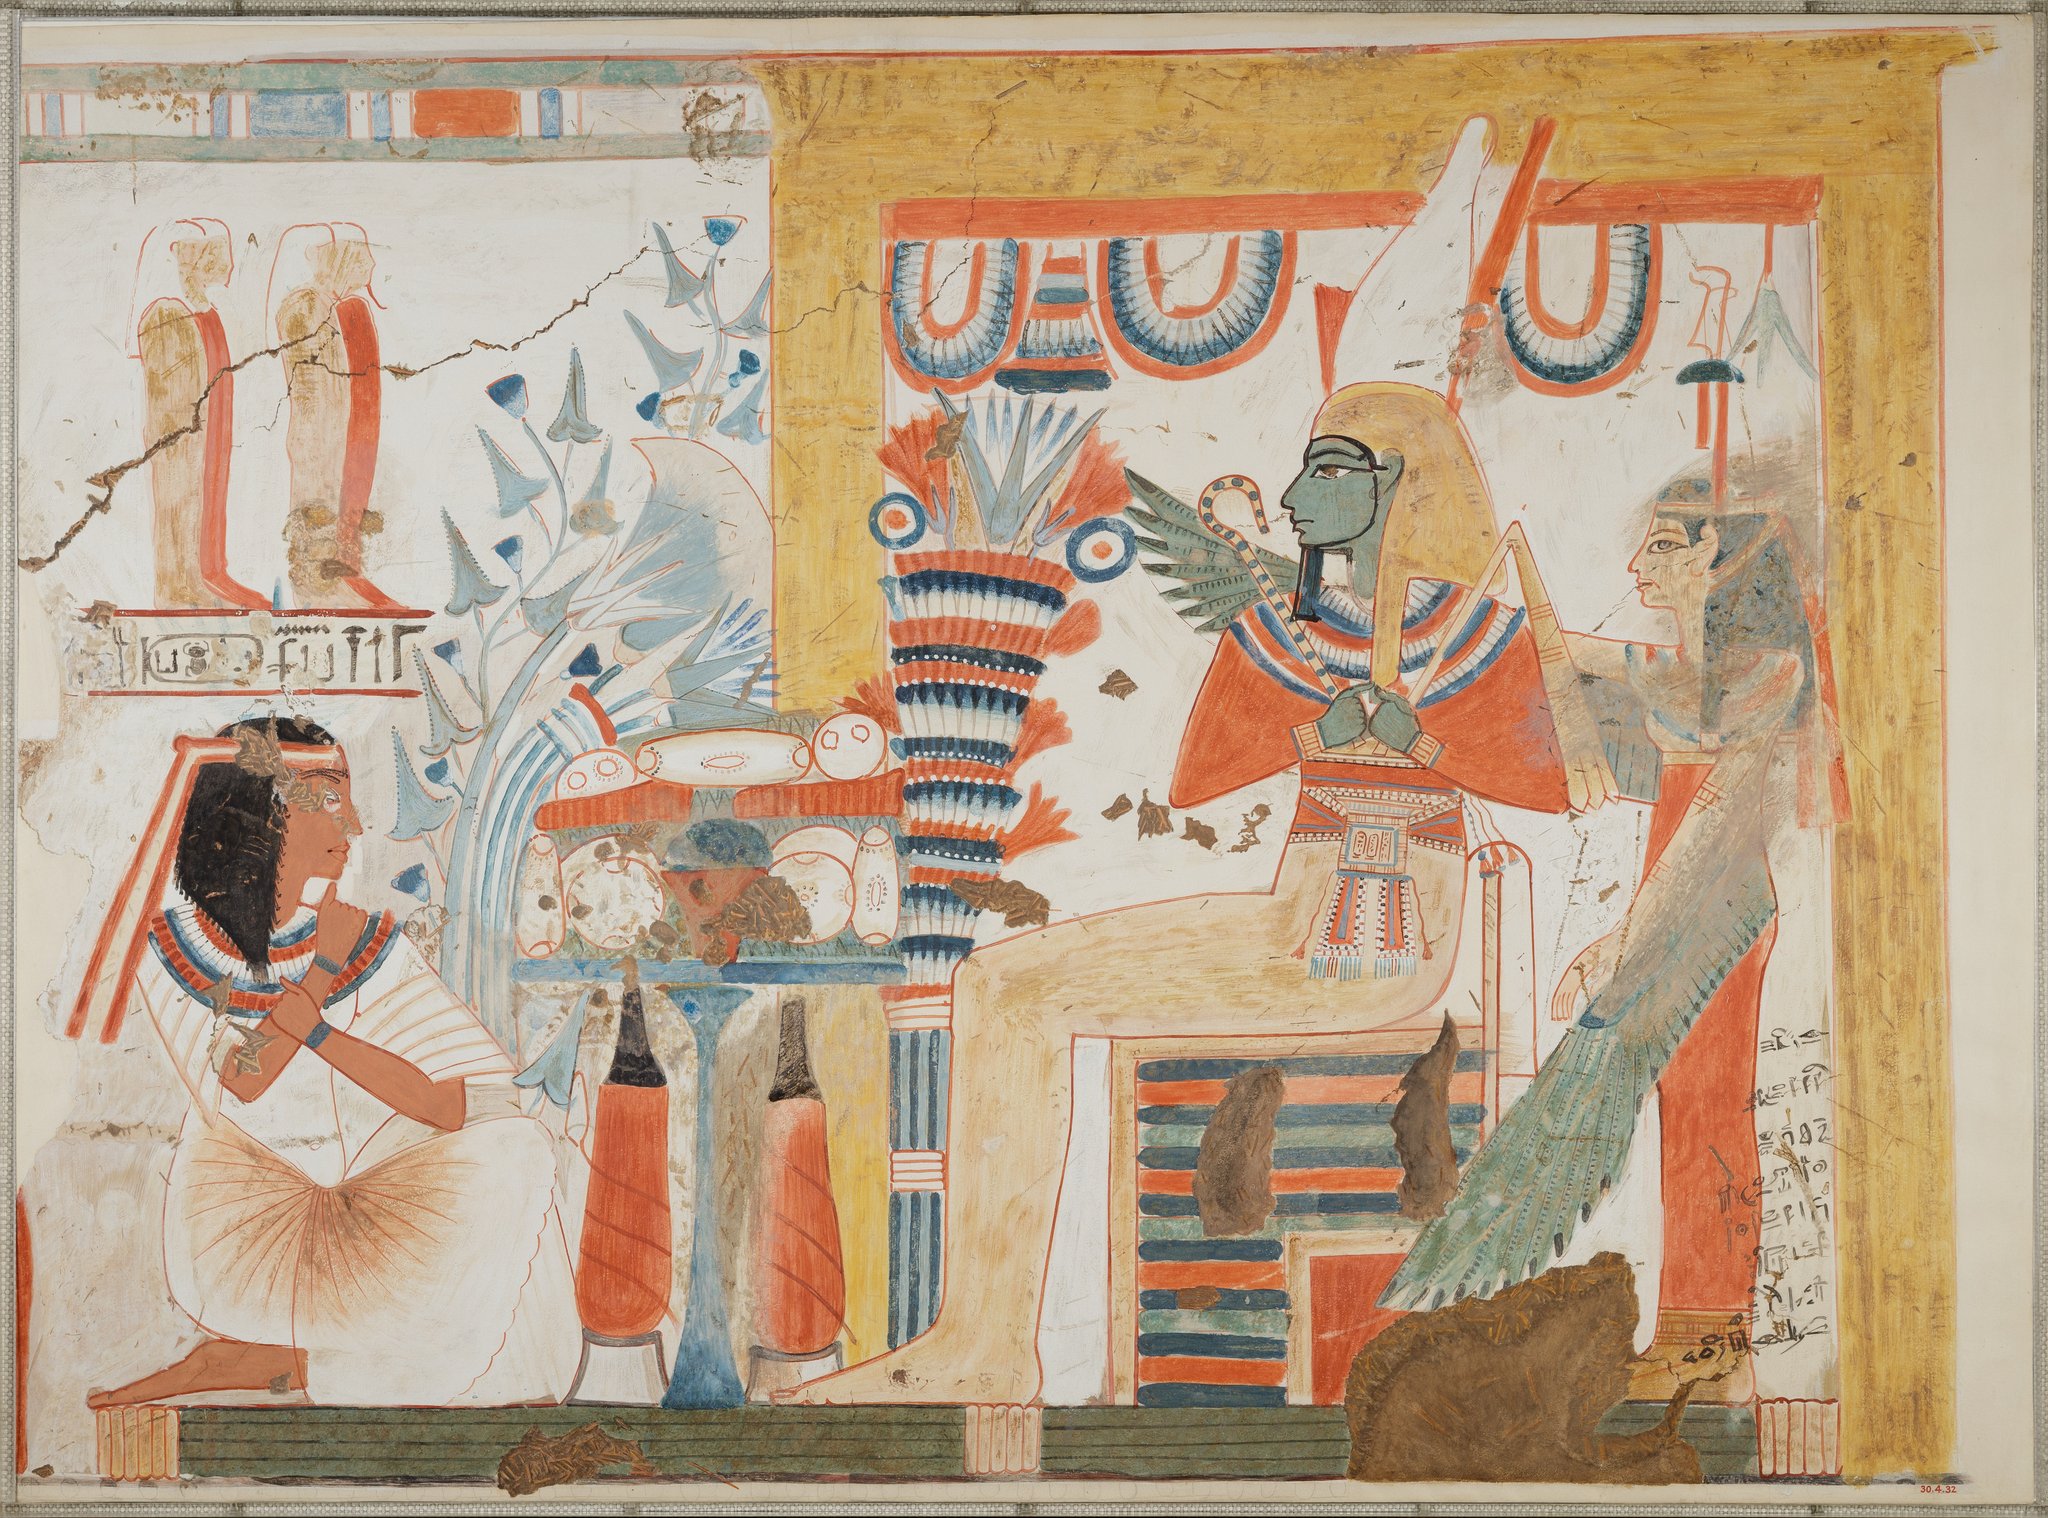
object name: facsimile, userhat tt 51, osiris, goddess of west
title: Userhat Kneeling Before Osiris and the Goddess of the West, Tomb of Userhat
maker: norman de garis davies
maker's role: artist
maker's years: 1865-1941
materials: paper, paint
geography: egypt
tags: goddess